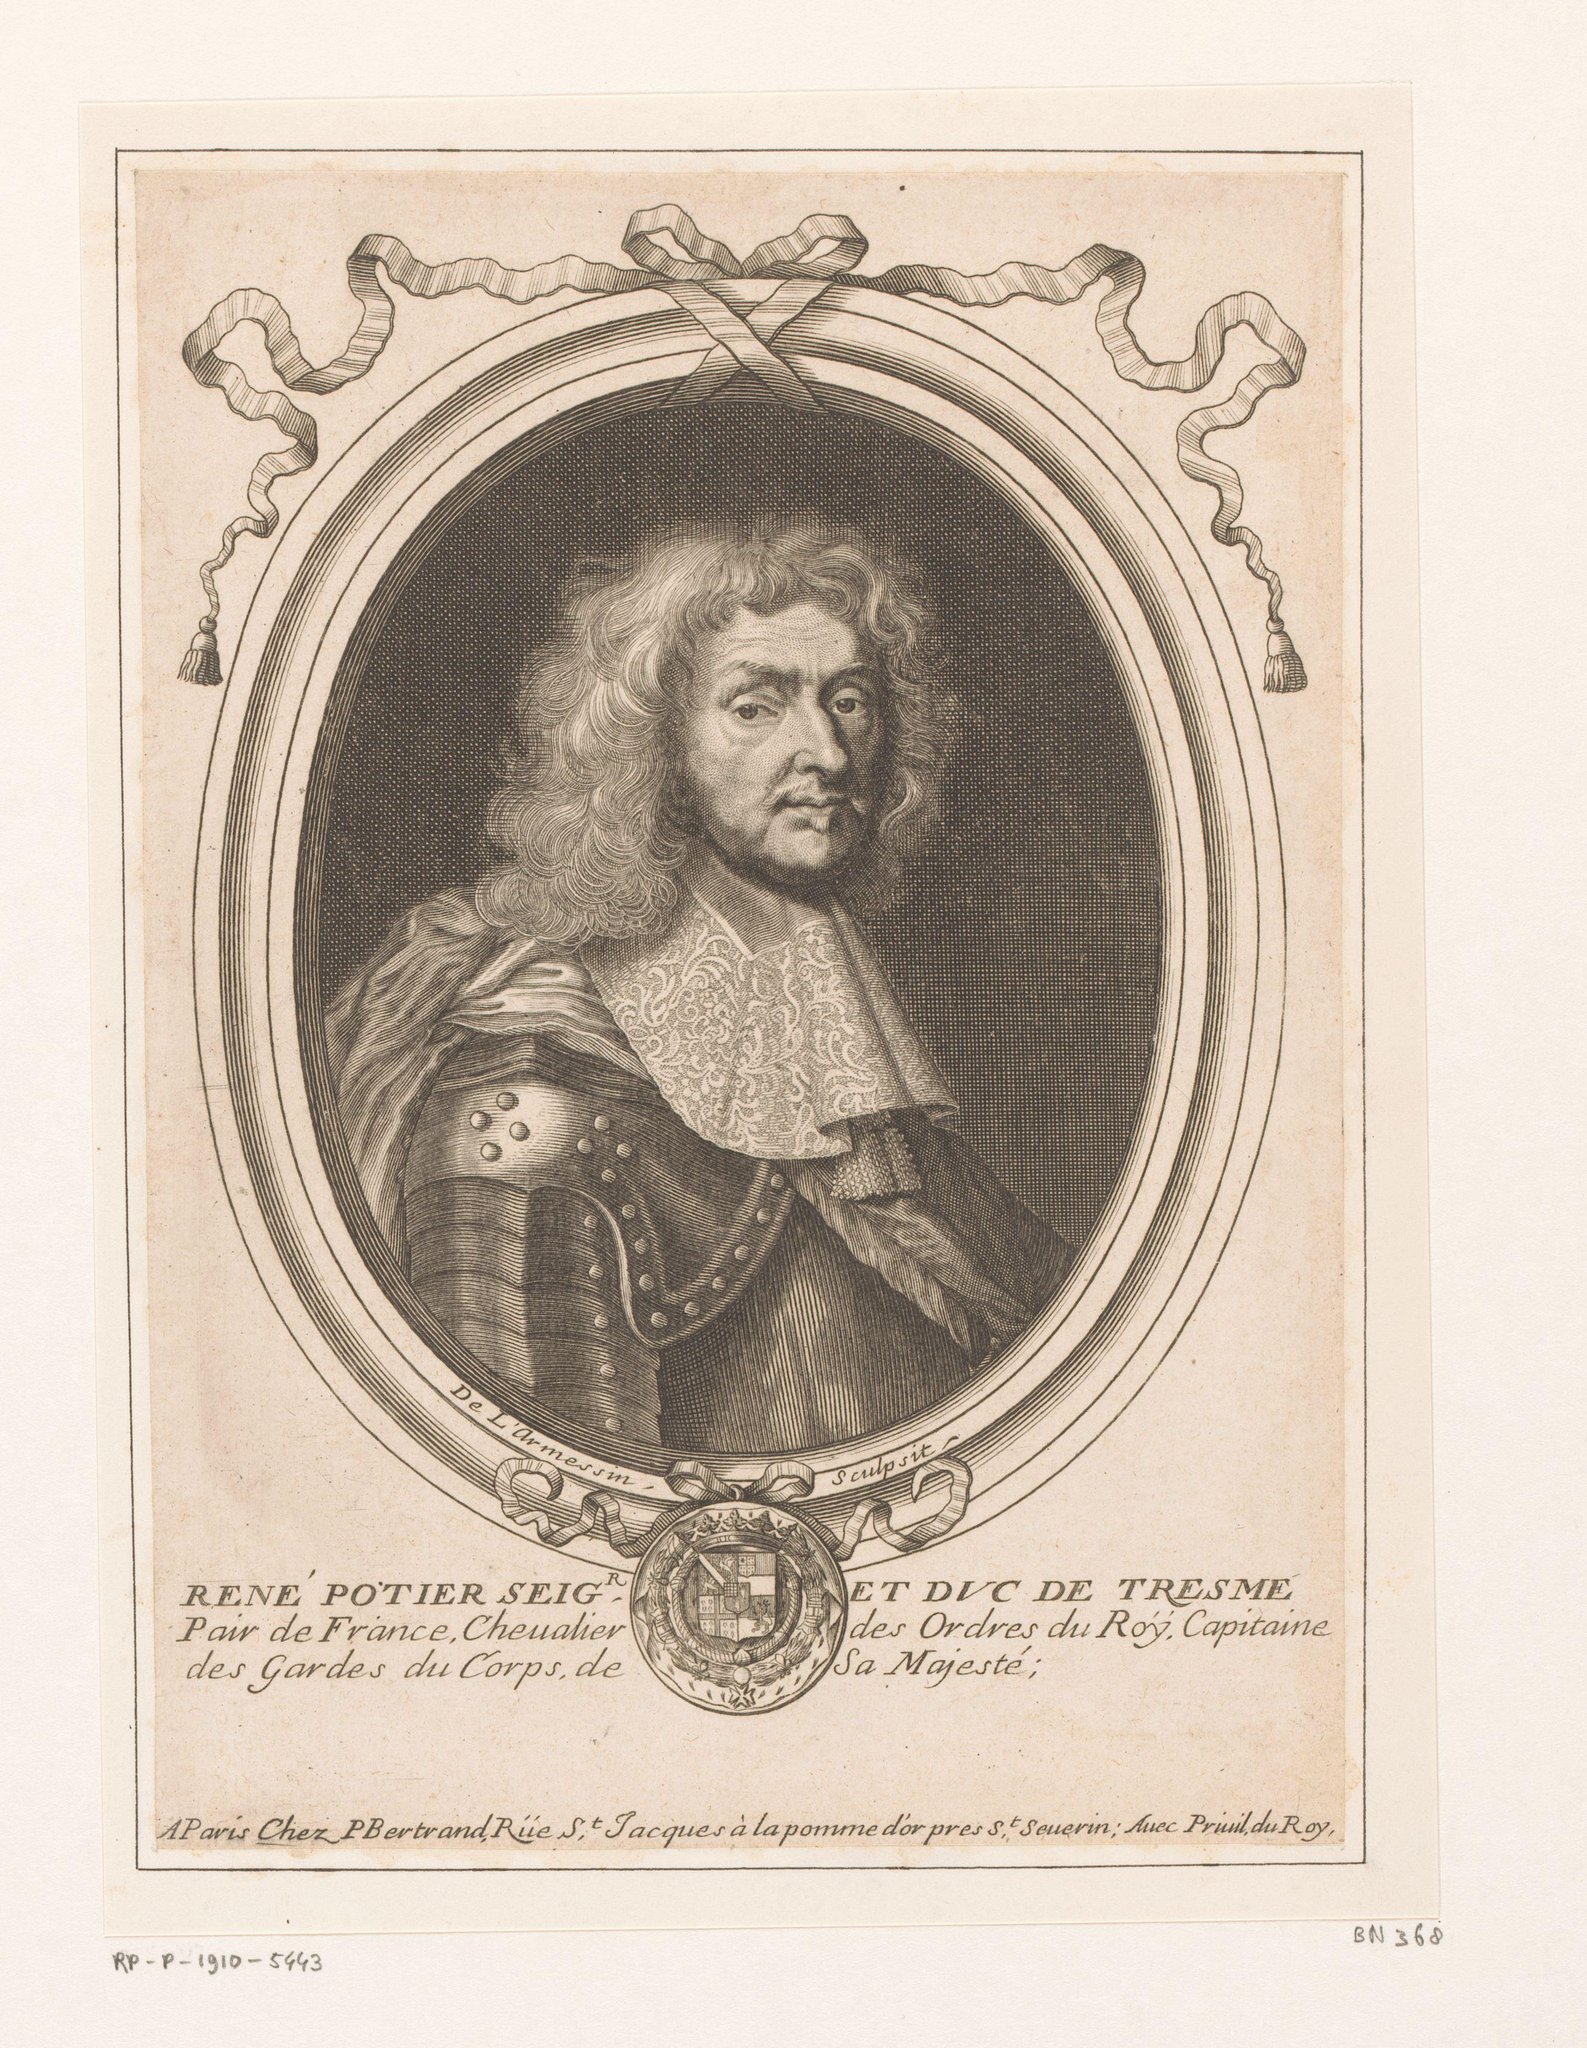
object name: print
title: René Potier Seig'r et Duc de Tresme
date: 1642-1678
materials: paper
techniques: engraving, etching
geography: france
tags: paris, historical persons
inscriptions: collector's mark: Lugt 2228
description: Maakt deel uit van een grootschalige serie met portretten van prominente figuren. Binnen de serie bevindt zich een sectie getiteld 'Les Augustes Représentations De tous les Roys De France depuis Pharamond Iusqu'à Louys XIIII'. De serie werd respectievelijk uitgegeven door Pierre Bertrand, door zijn weduwe en door De Larmessin zelf.